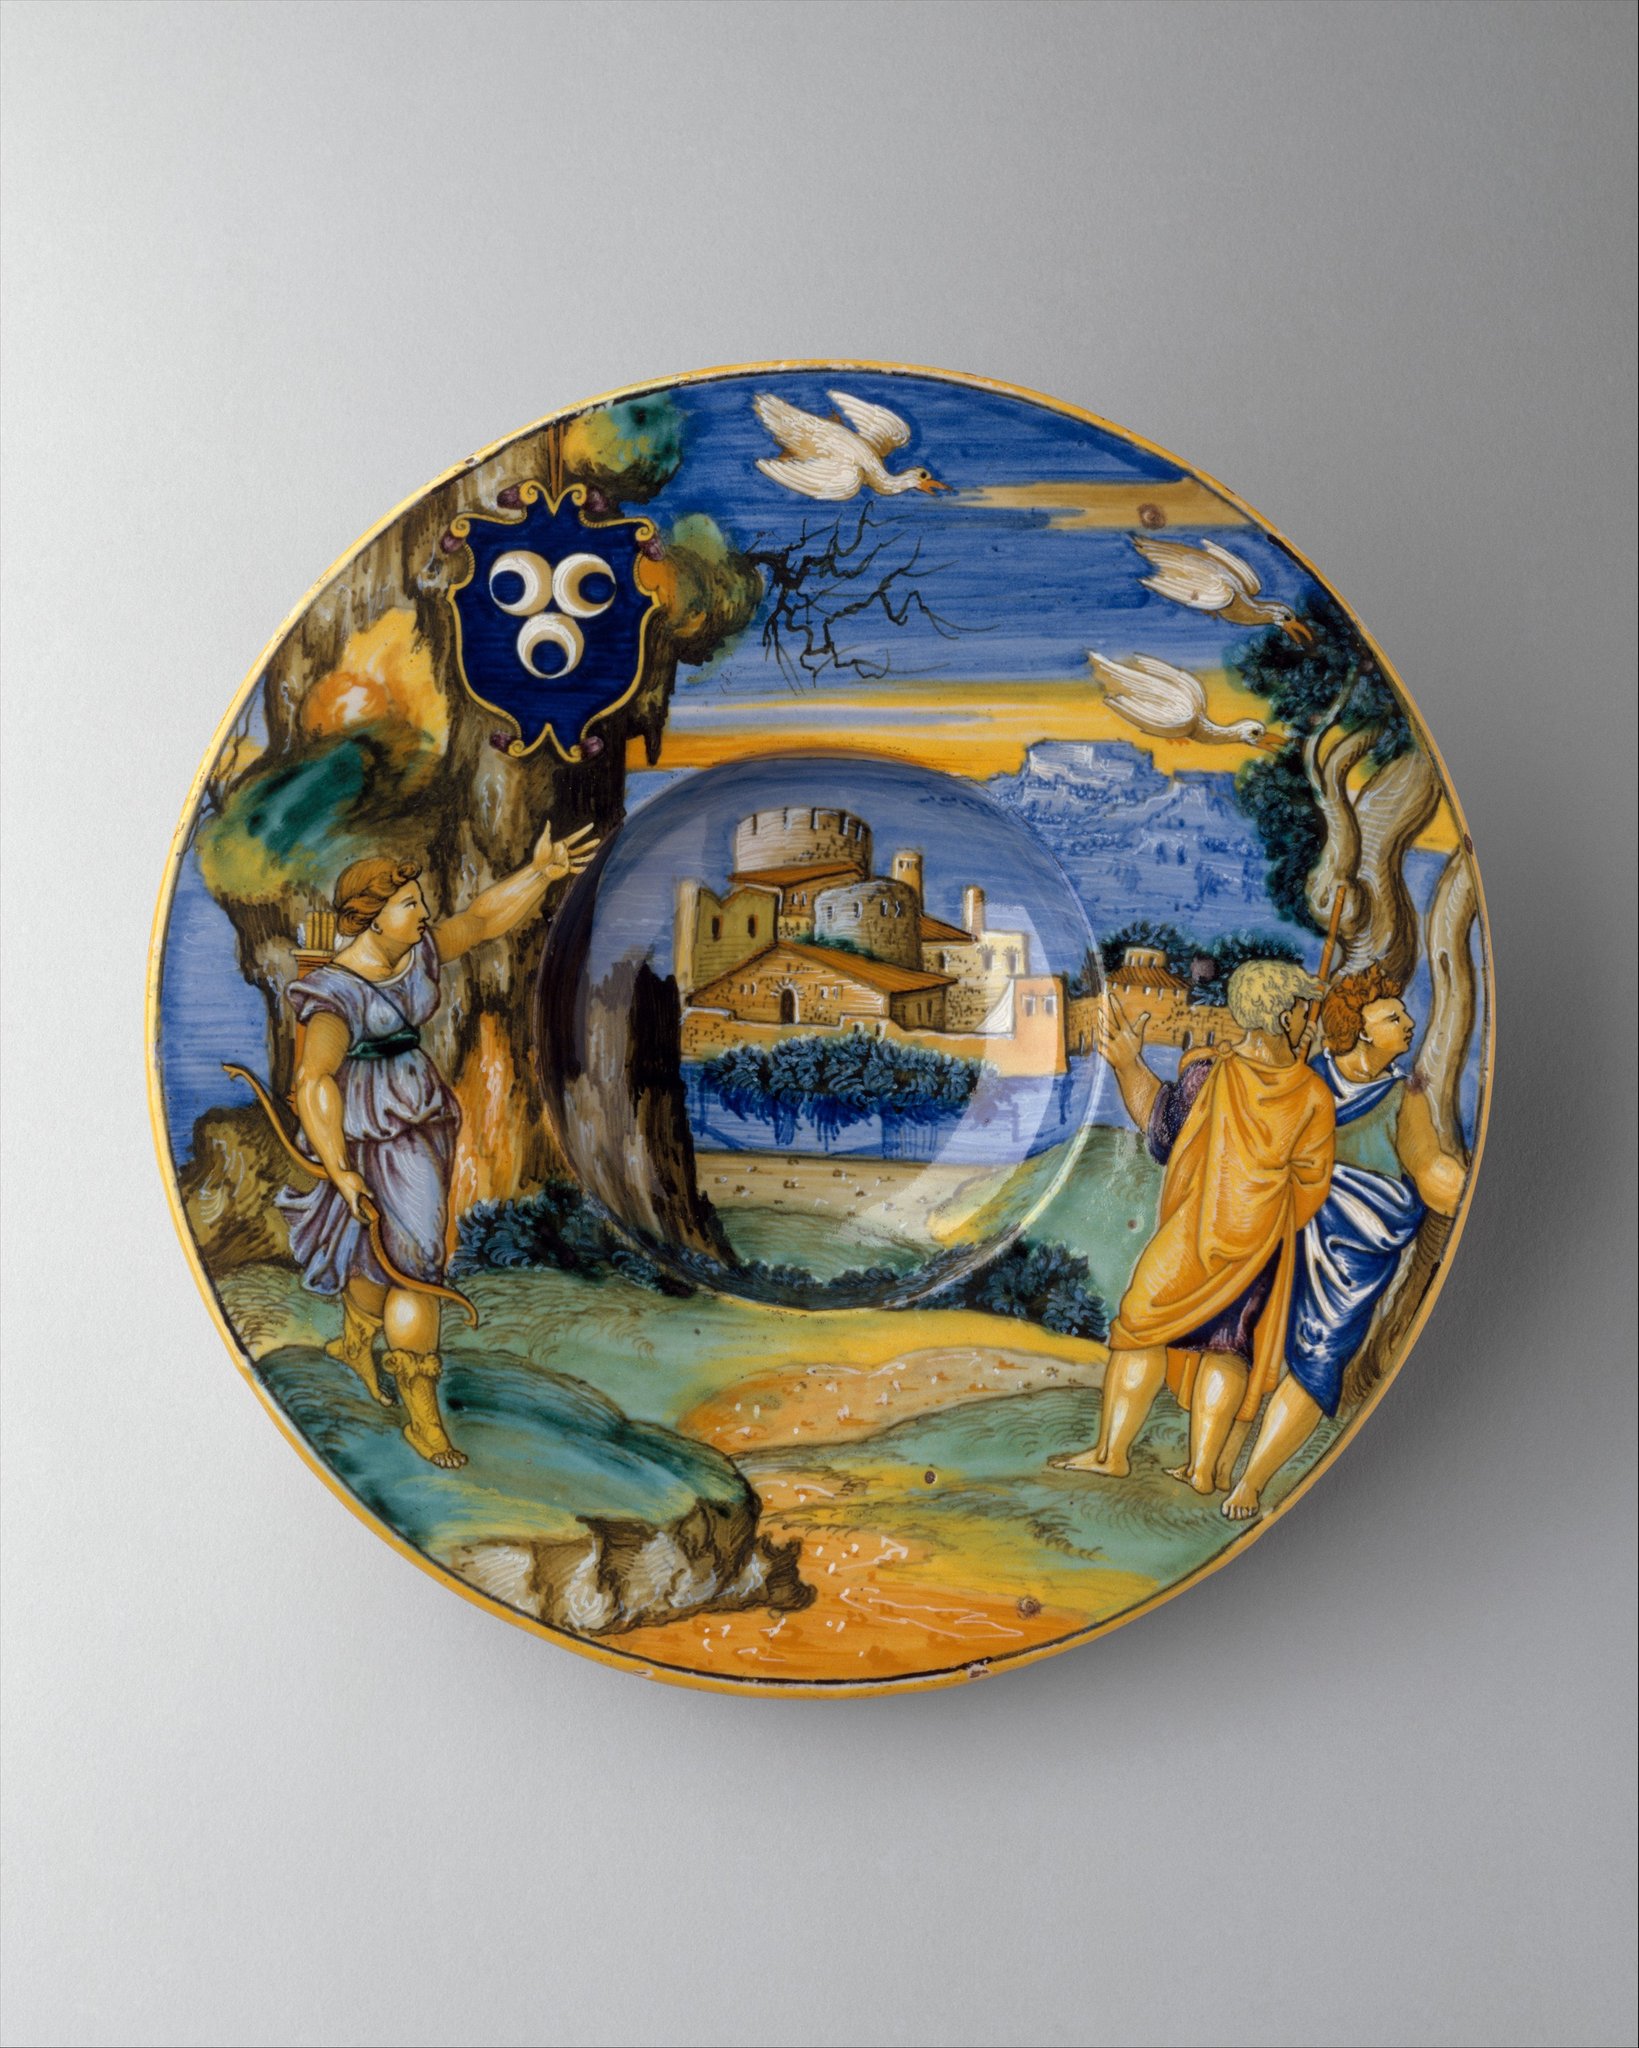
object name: plate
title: Plate (tondino)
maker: francesco xanto avelli da rovigo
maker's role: artist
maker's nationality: italian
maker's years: 1482-1542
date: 1530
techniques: maiolica, glazing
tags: birds,men,women,coat of arms